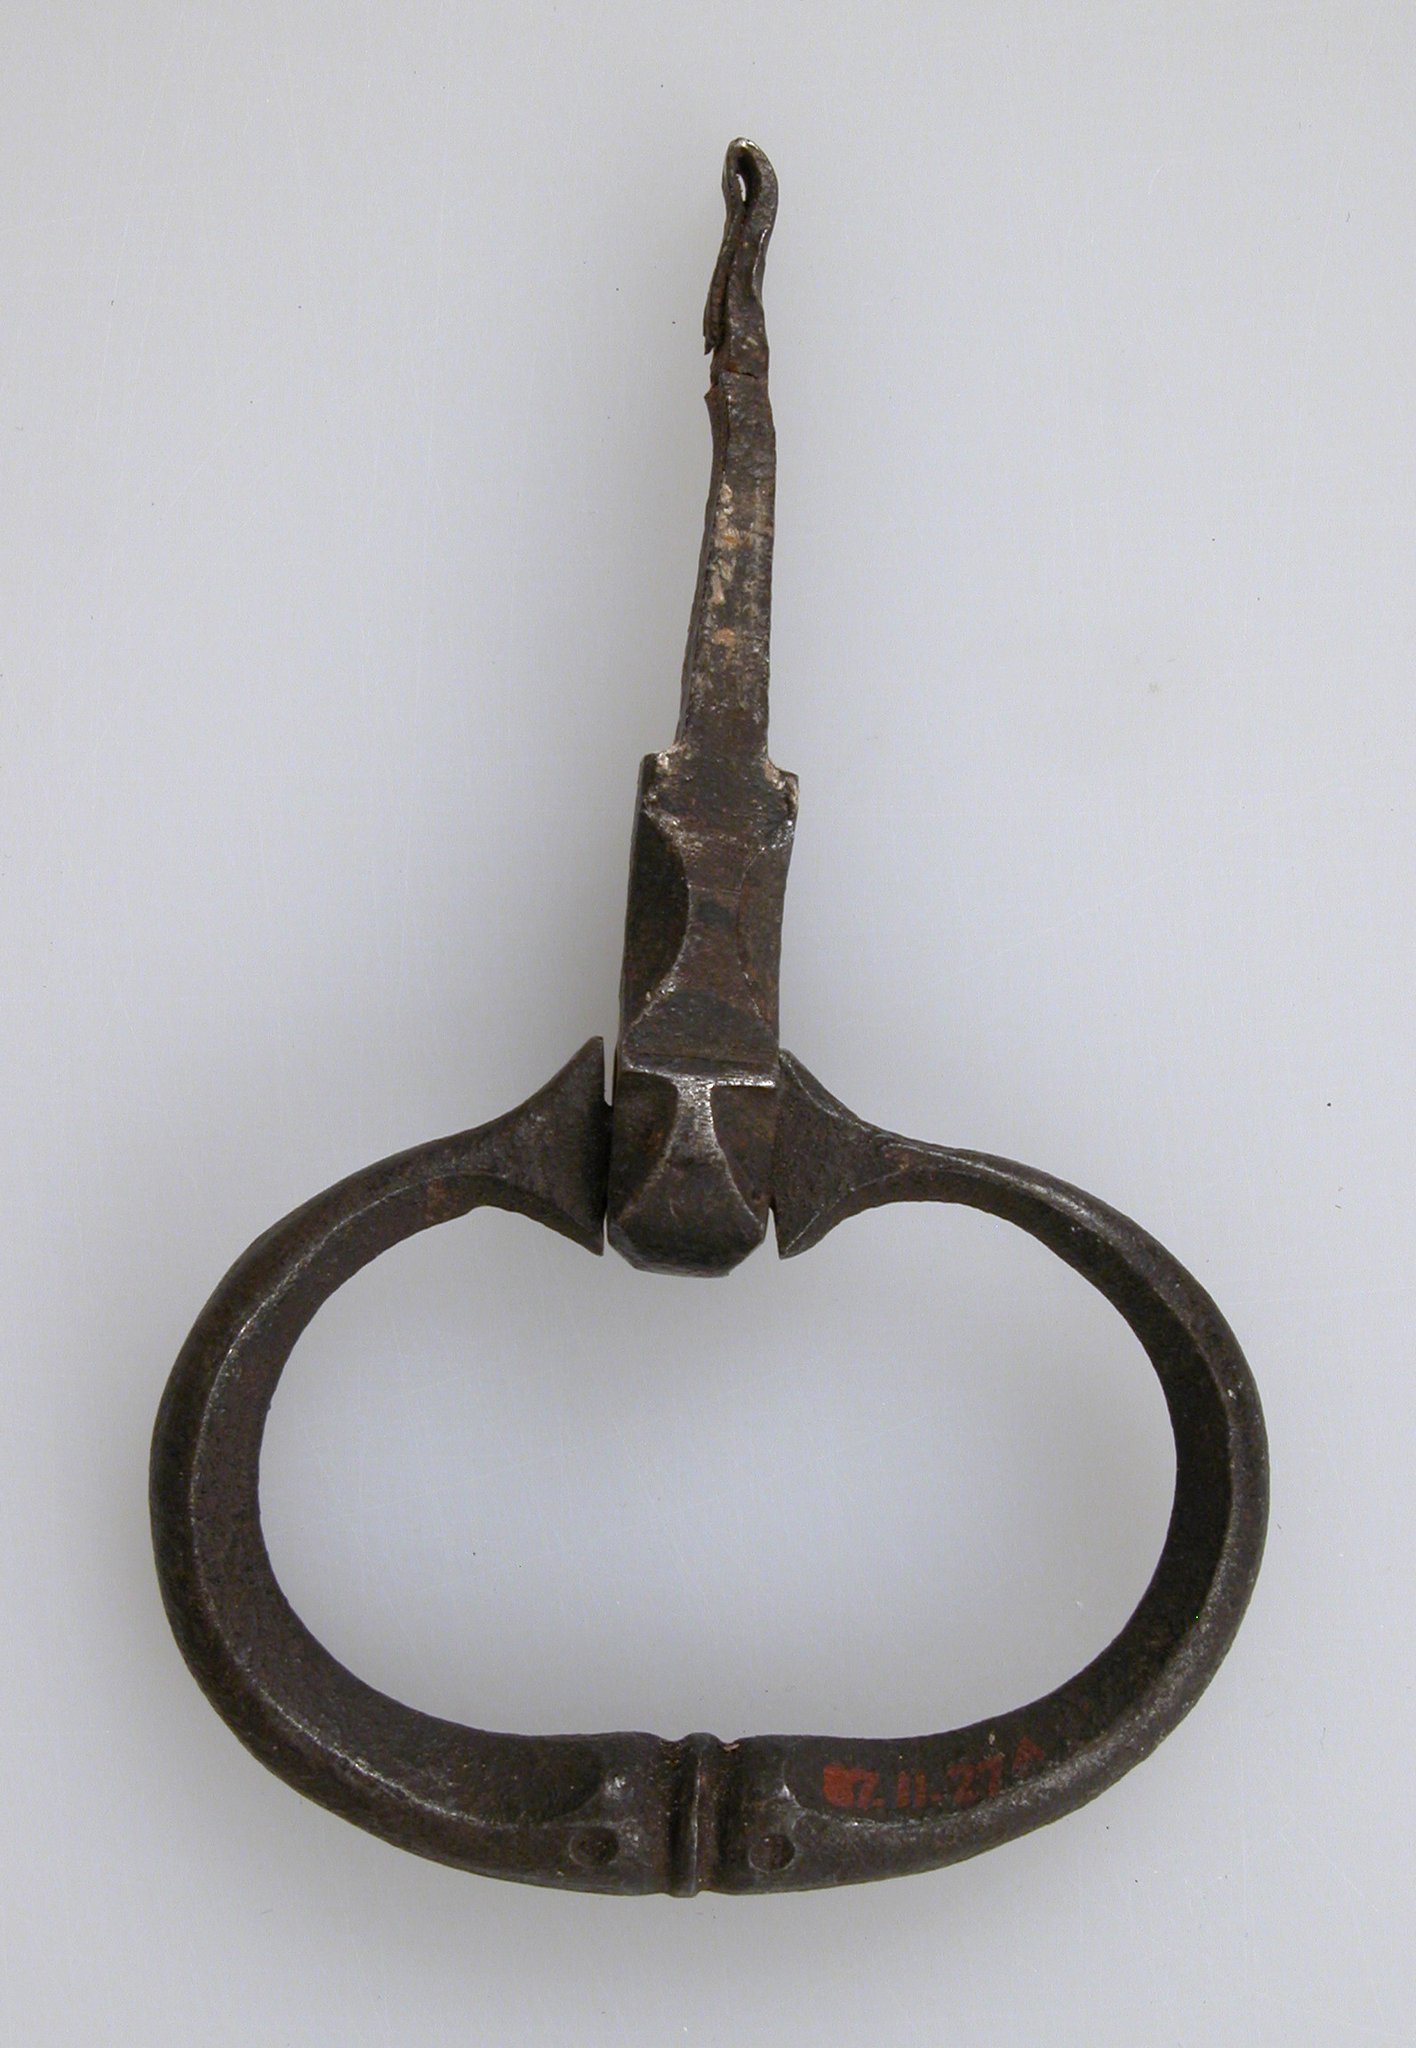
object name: door handle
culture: german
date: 1401-1500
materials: iron